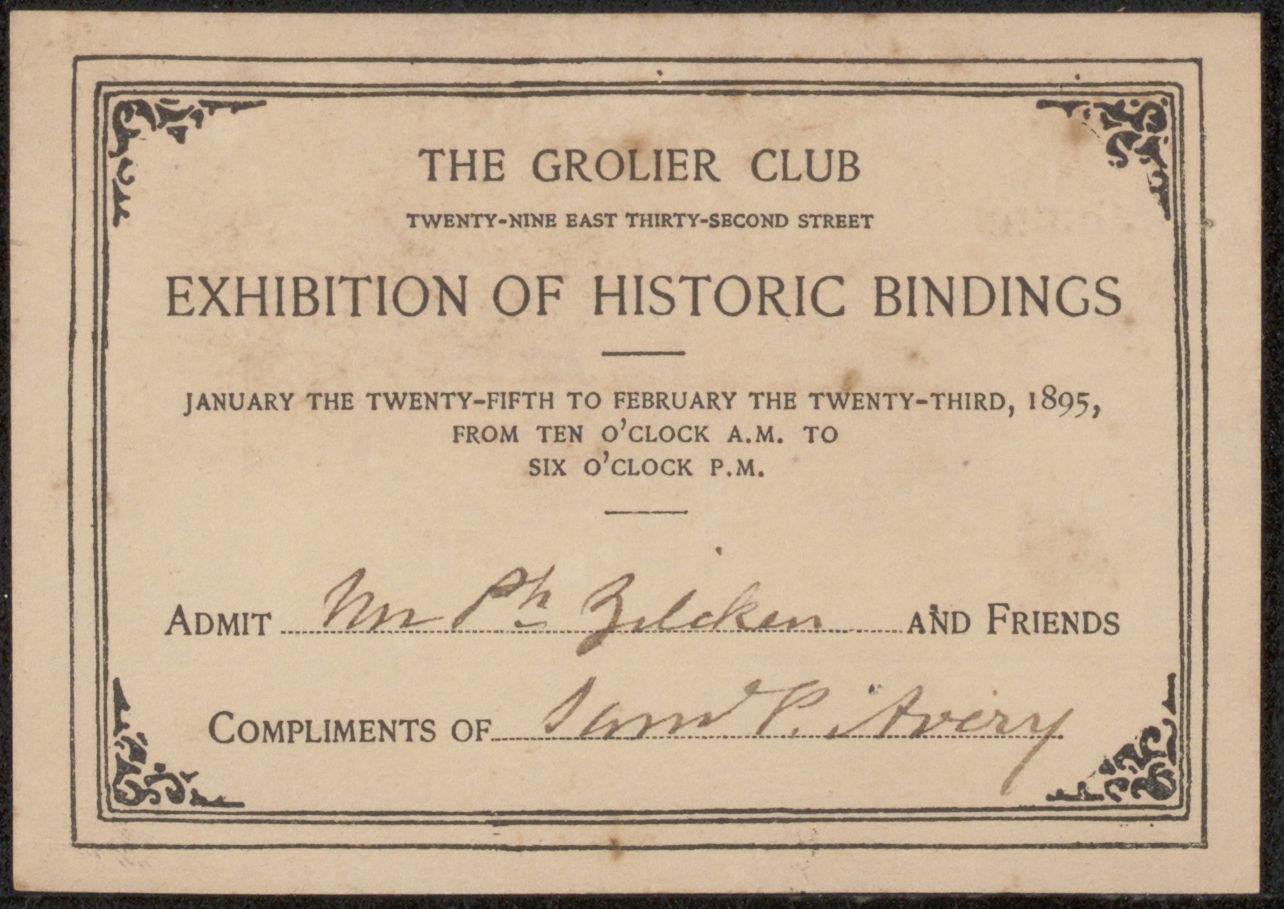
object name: admission ticket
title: Toegangskaart uit archief Philip Zilcken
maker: samuel putnam avery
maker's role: verzamelaar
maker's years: 1822-1904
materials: ink, paper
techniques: pen, printing, writing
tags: new york (city), samuel putnam avery, the hague, painter, philip zilcken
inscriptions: collector's mark: ‘RPK’